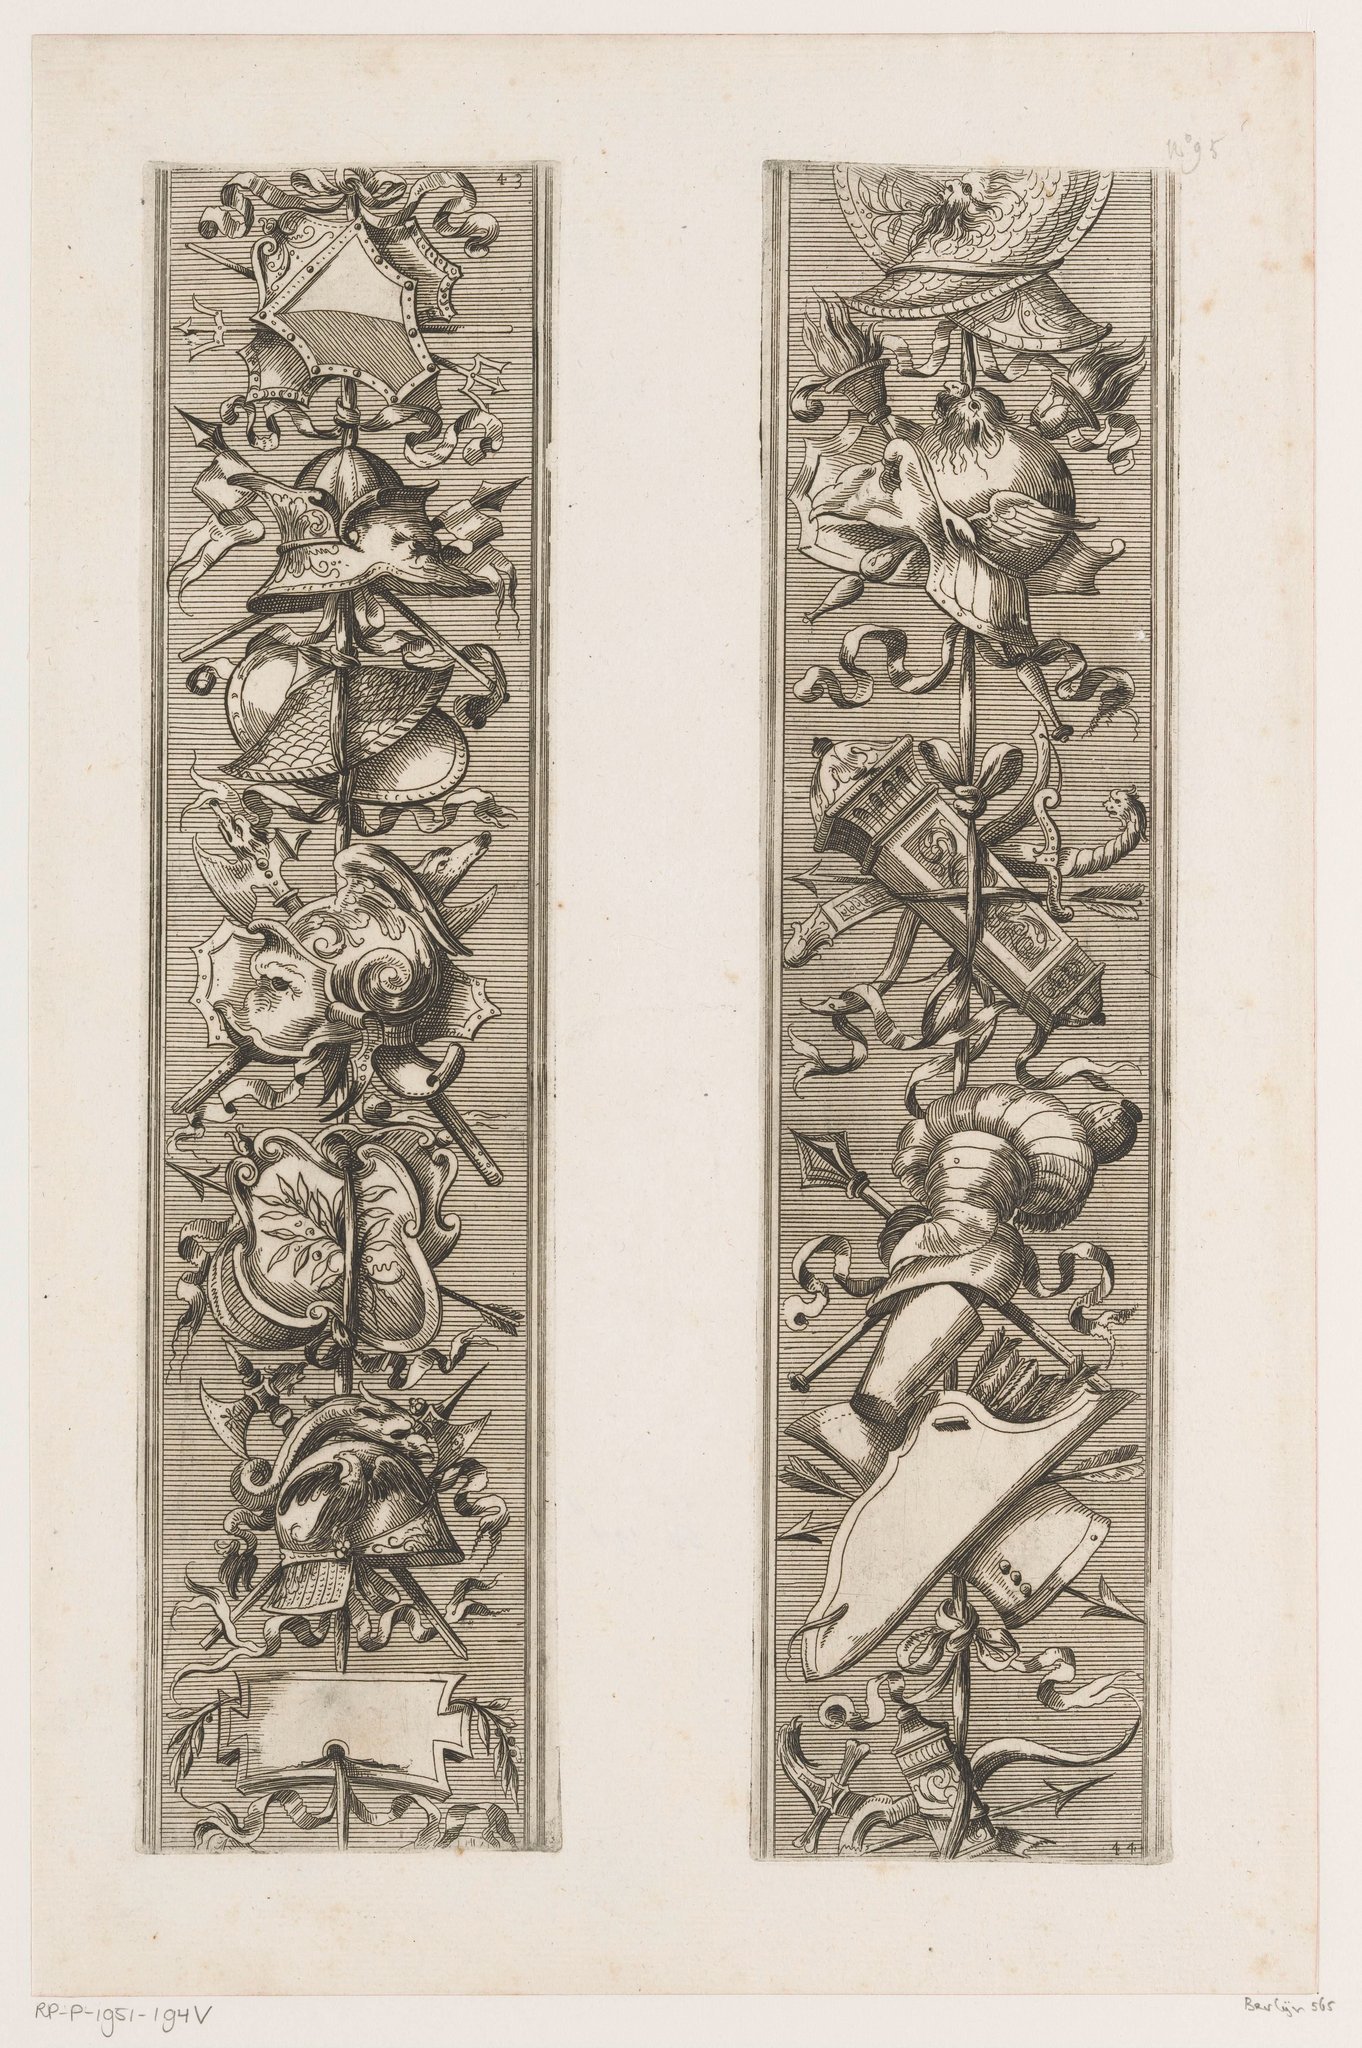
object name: print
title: Freggi dell' Architettura da Agostino Mitelli pittore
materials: paper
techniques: etching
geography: rome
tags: ornament ~ candelabrum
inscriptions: collector's mark: Lugt 2228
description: Deze prent maakt deel uit van een reeks van 48 prenten plus een titelprent. Mitelli maakte tekeningen van marmeren pilasterdecoraties van de poort van de S. Bartolomeo di Porta Ravegnana in Bologna. Deze prenten zijn vervolgens naar die tekeningen gemaakt.